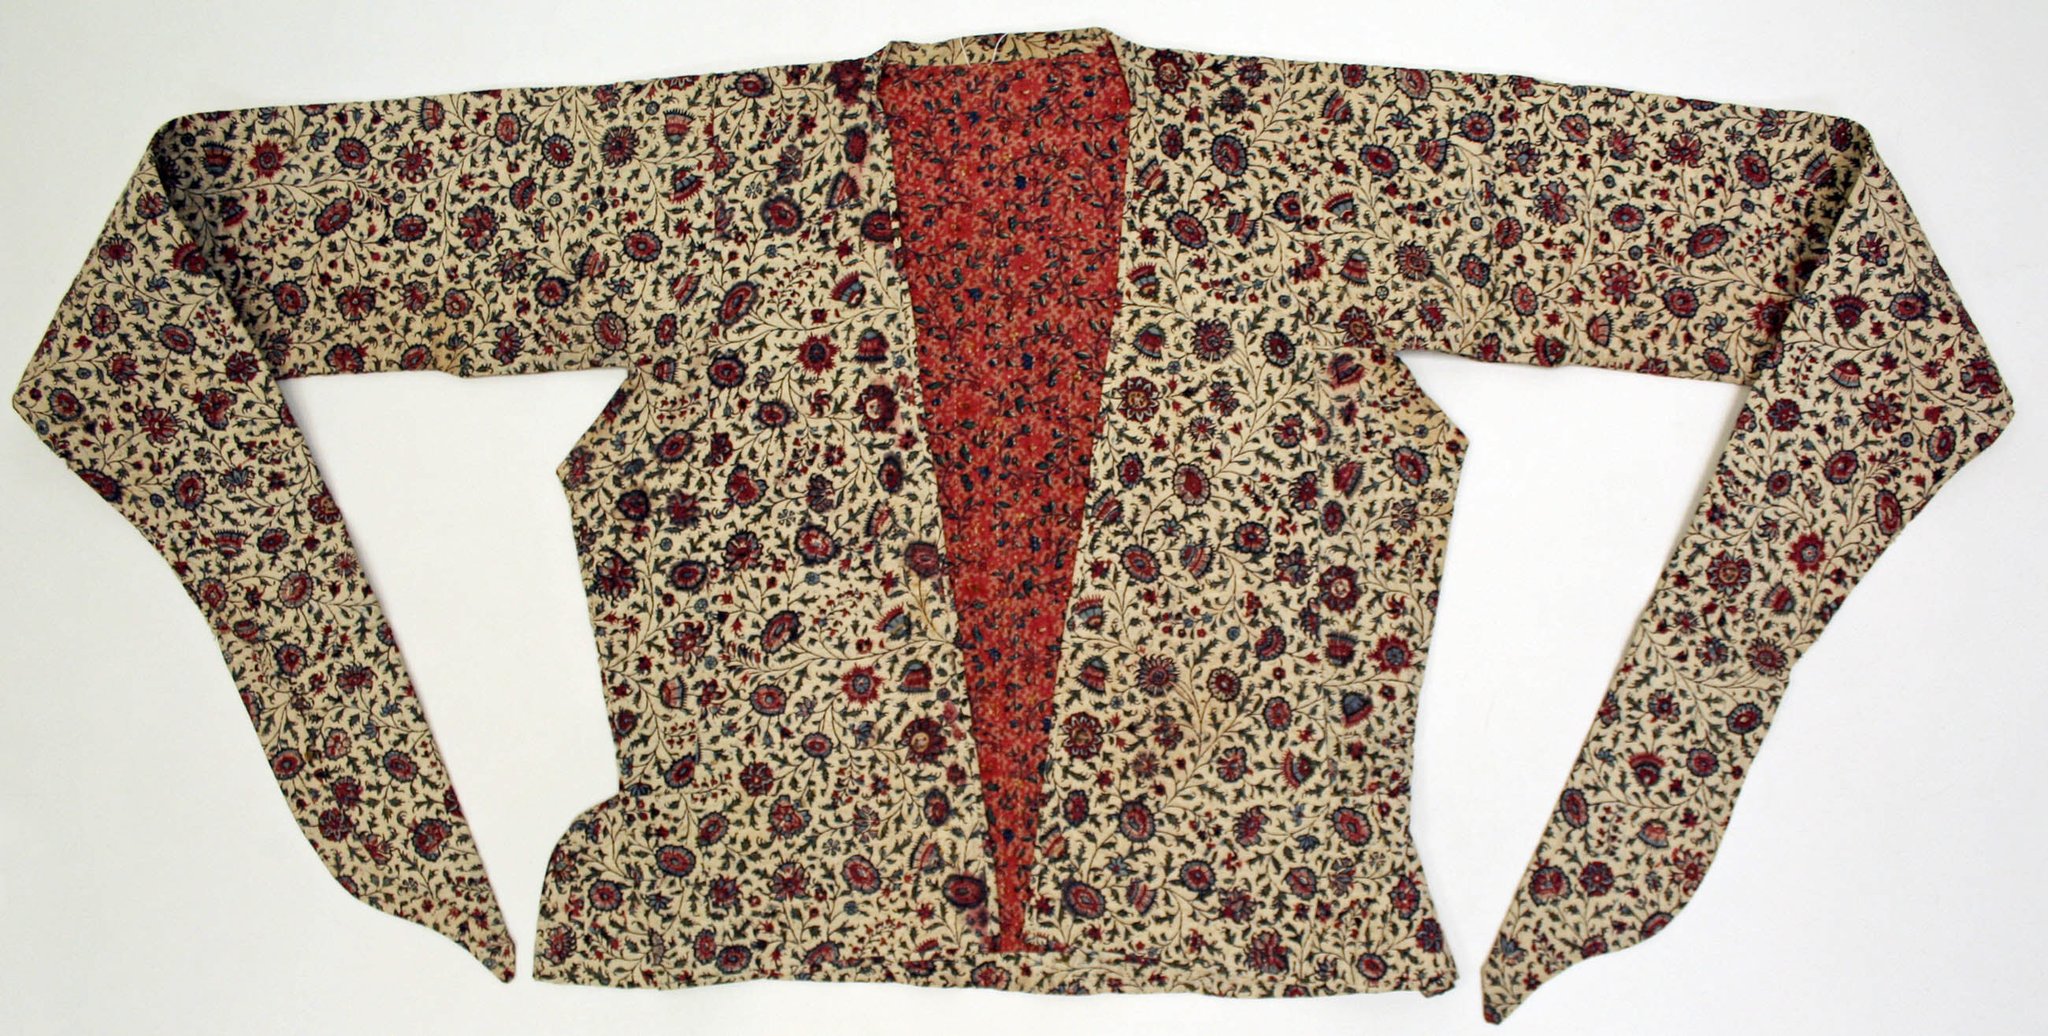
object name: jacket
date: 1801-1900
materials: cotton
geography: iran